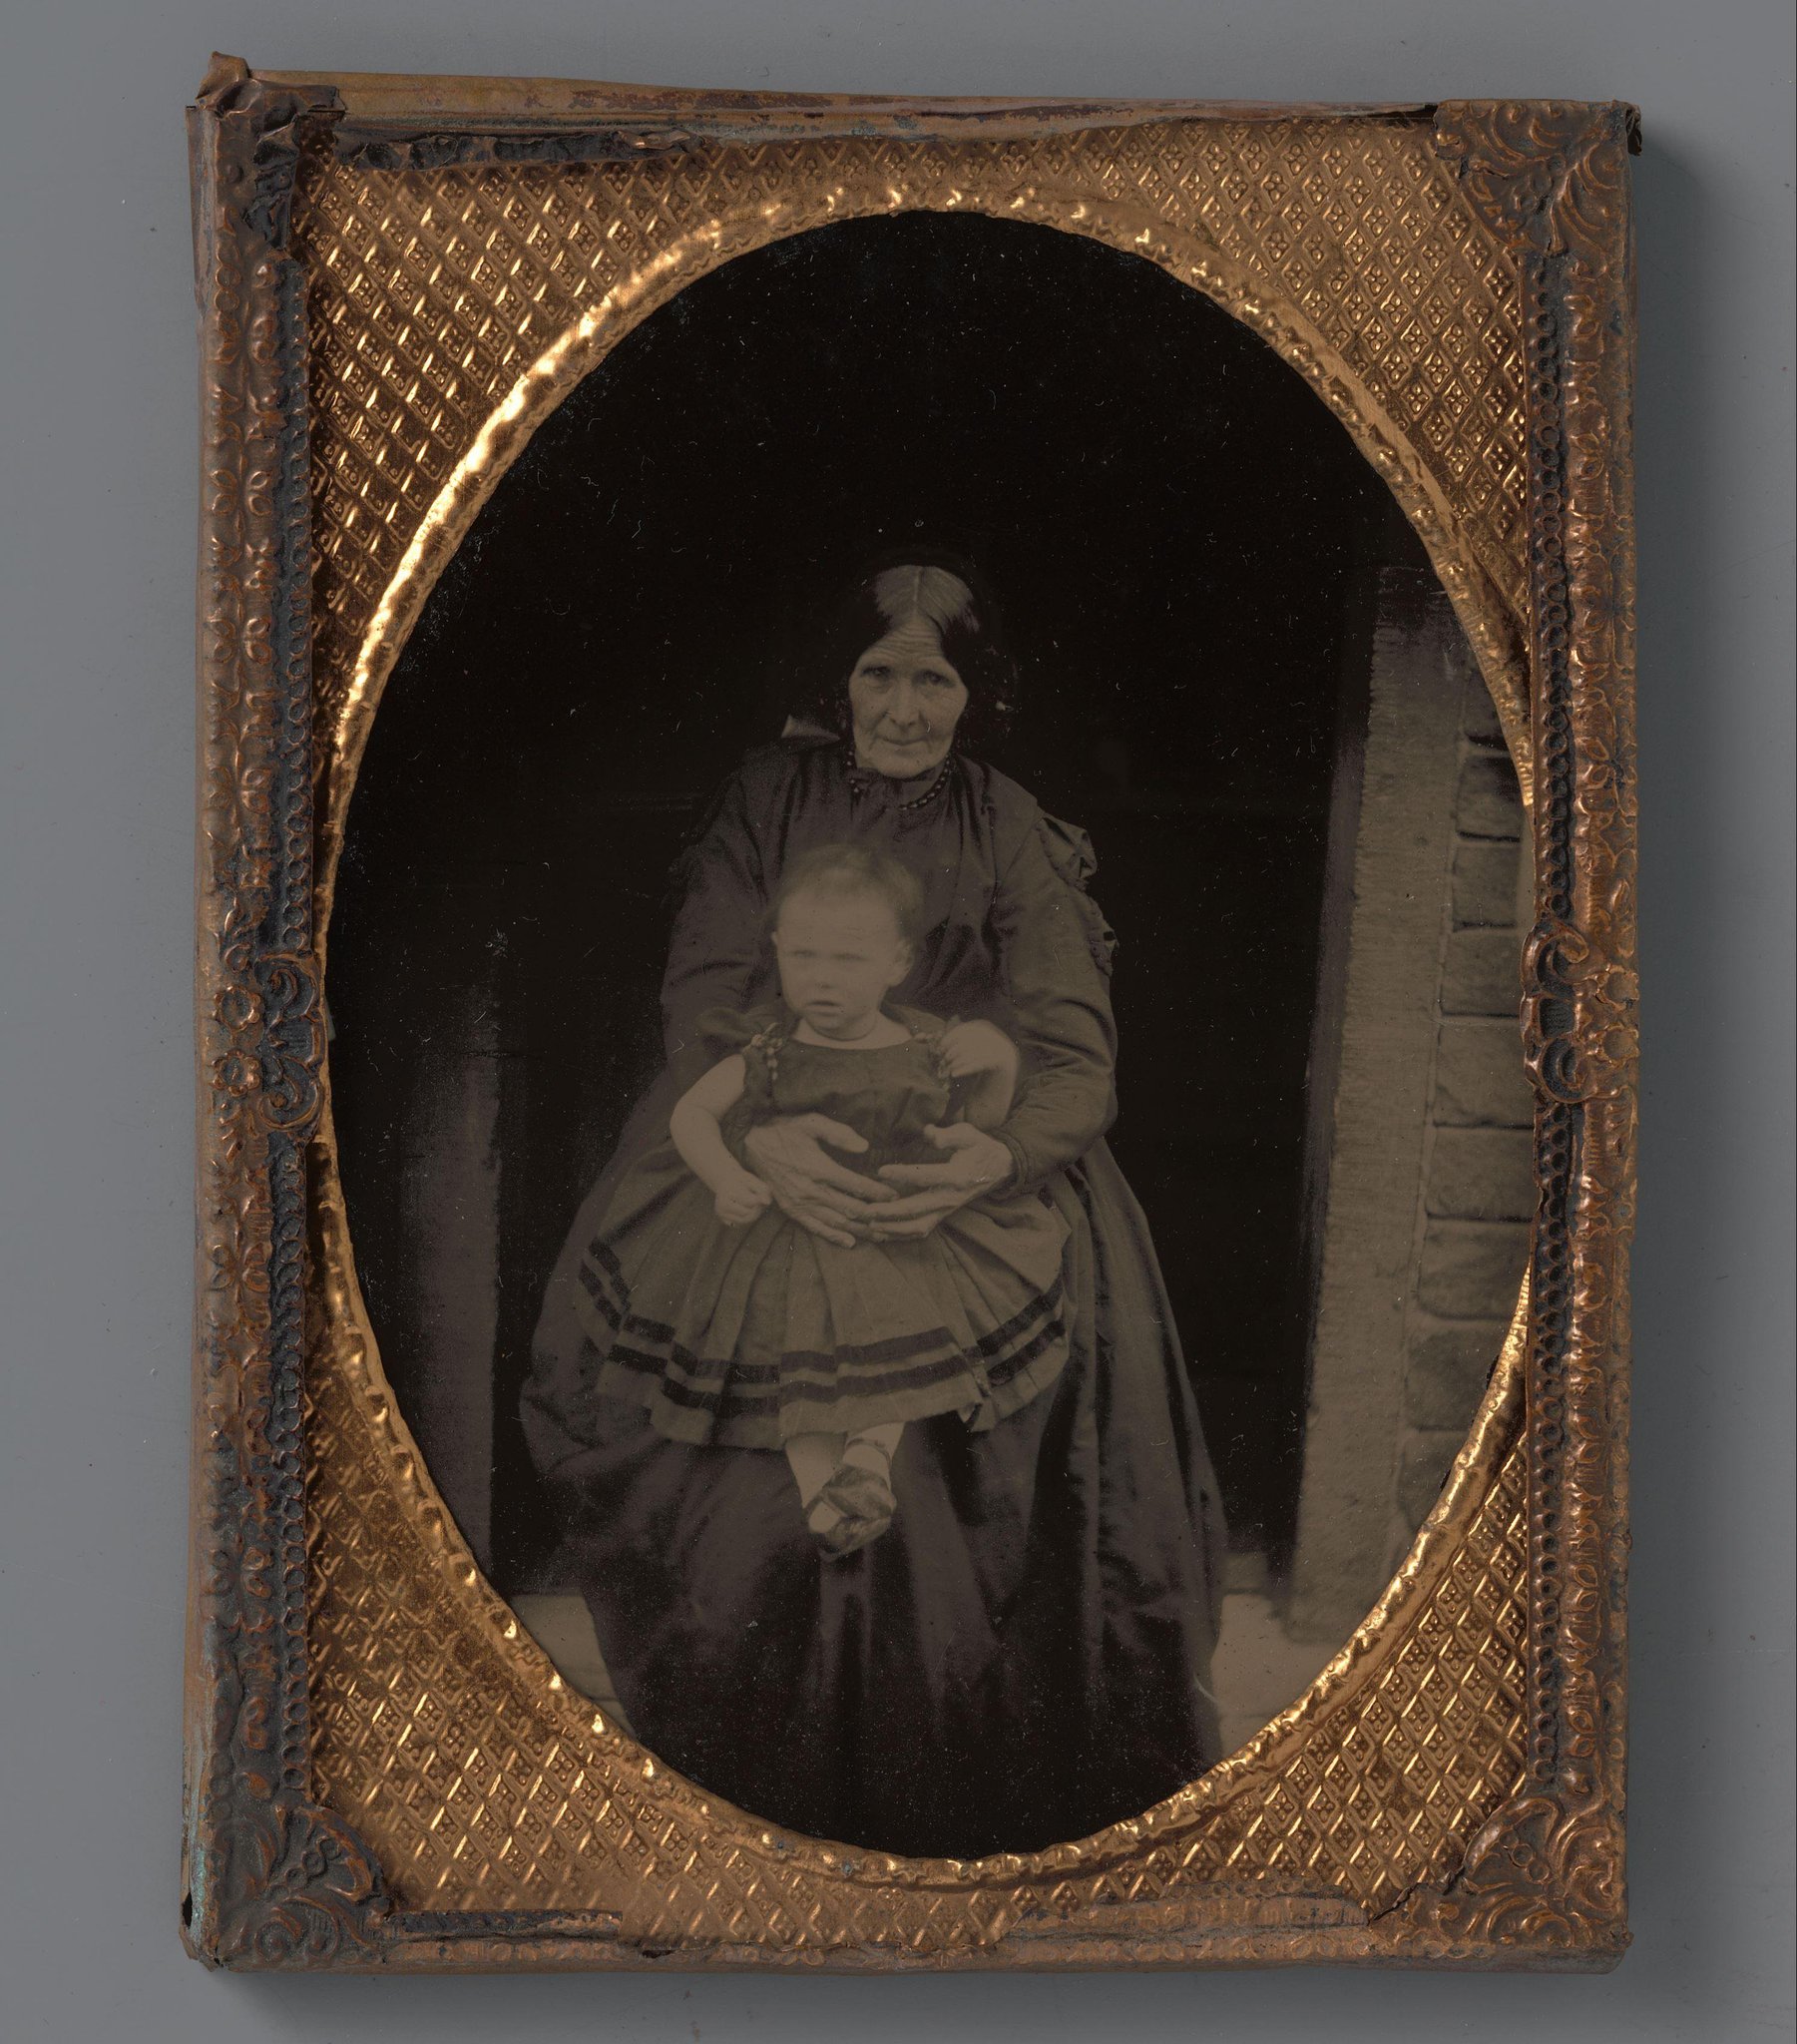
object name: photograph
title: Portret van een onbekende vrouw met kind op schoot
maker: silas a. holmes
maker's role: fotograaf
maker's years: 1820-1886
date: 1855-1870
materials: glass, metal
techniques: ambrotype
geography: bradford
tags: historical persons - bb - woman, old woman, toddler (female)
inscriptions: inscription: ‘S.Holmes, Photographer Bottom of Old Bowling Lane, Off Manch ester Road, Bradford’